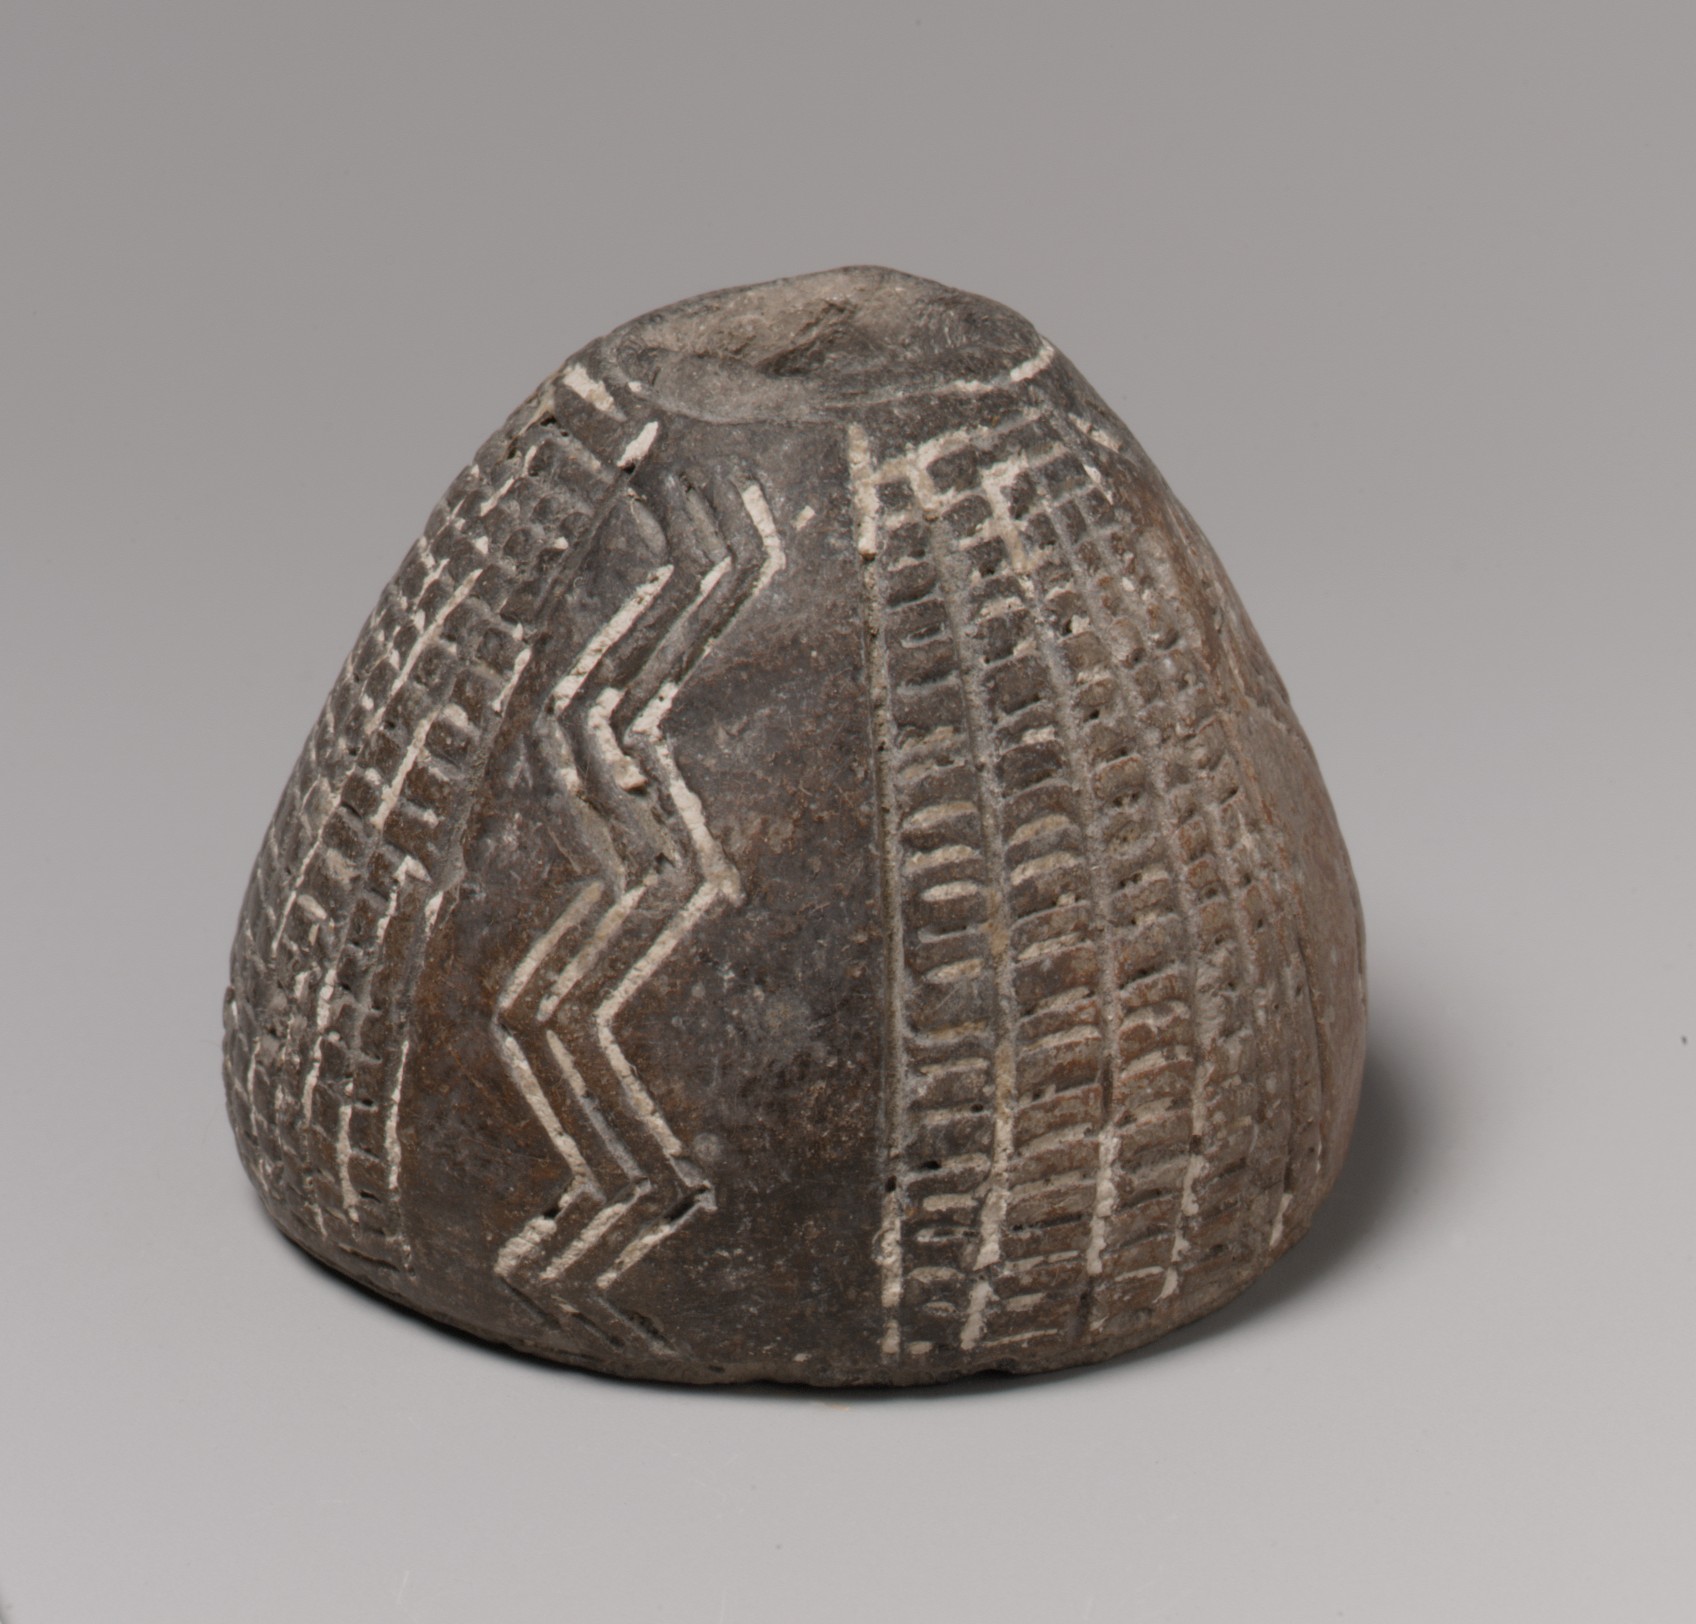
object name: spindle whorl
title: Terracotta spindle whorl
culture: cypriot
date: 1900-1600 BCE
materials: terracotta